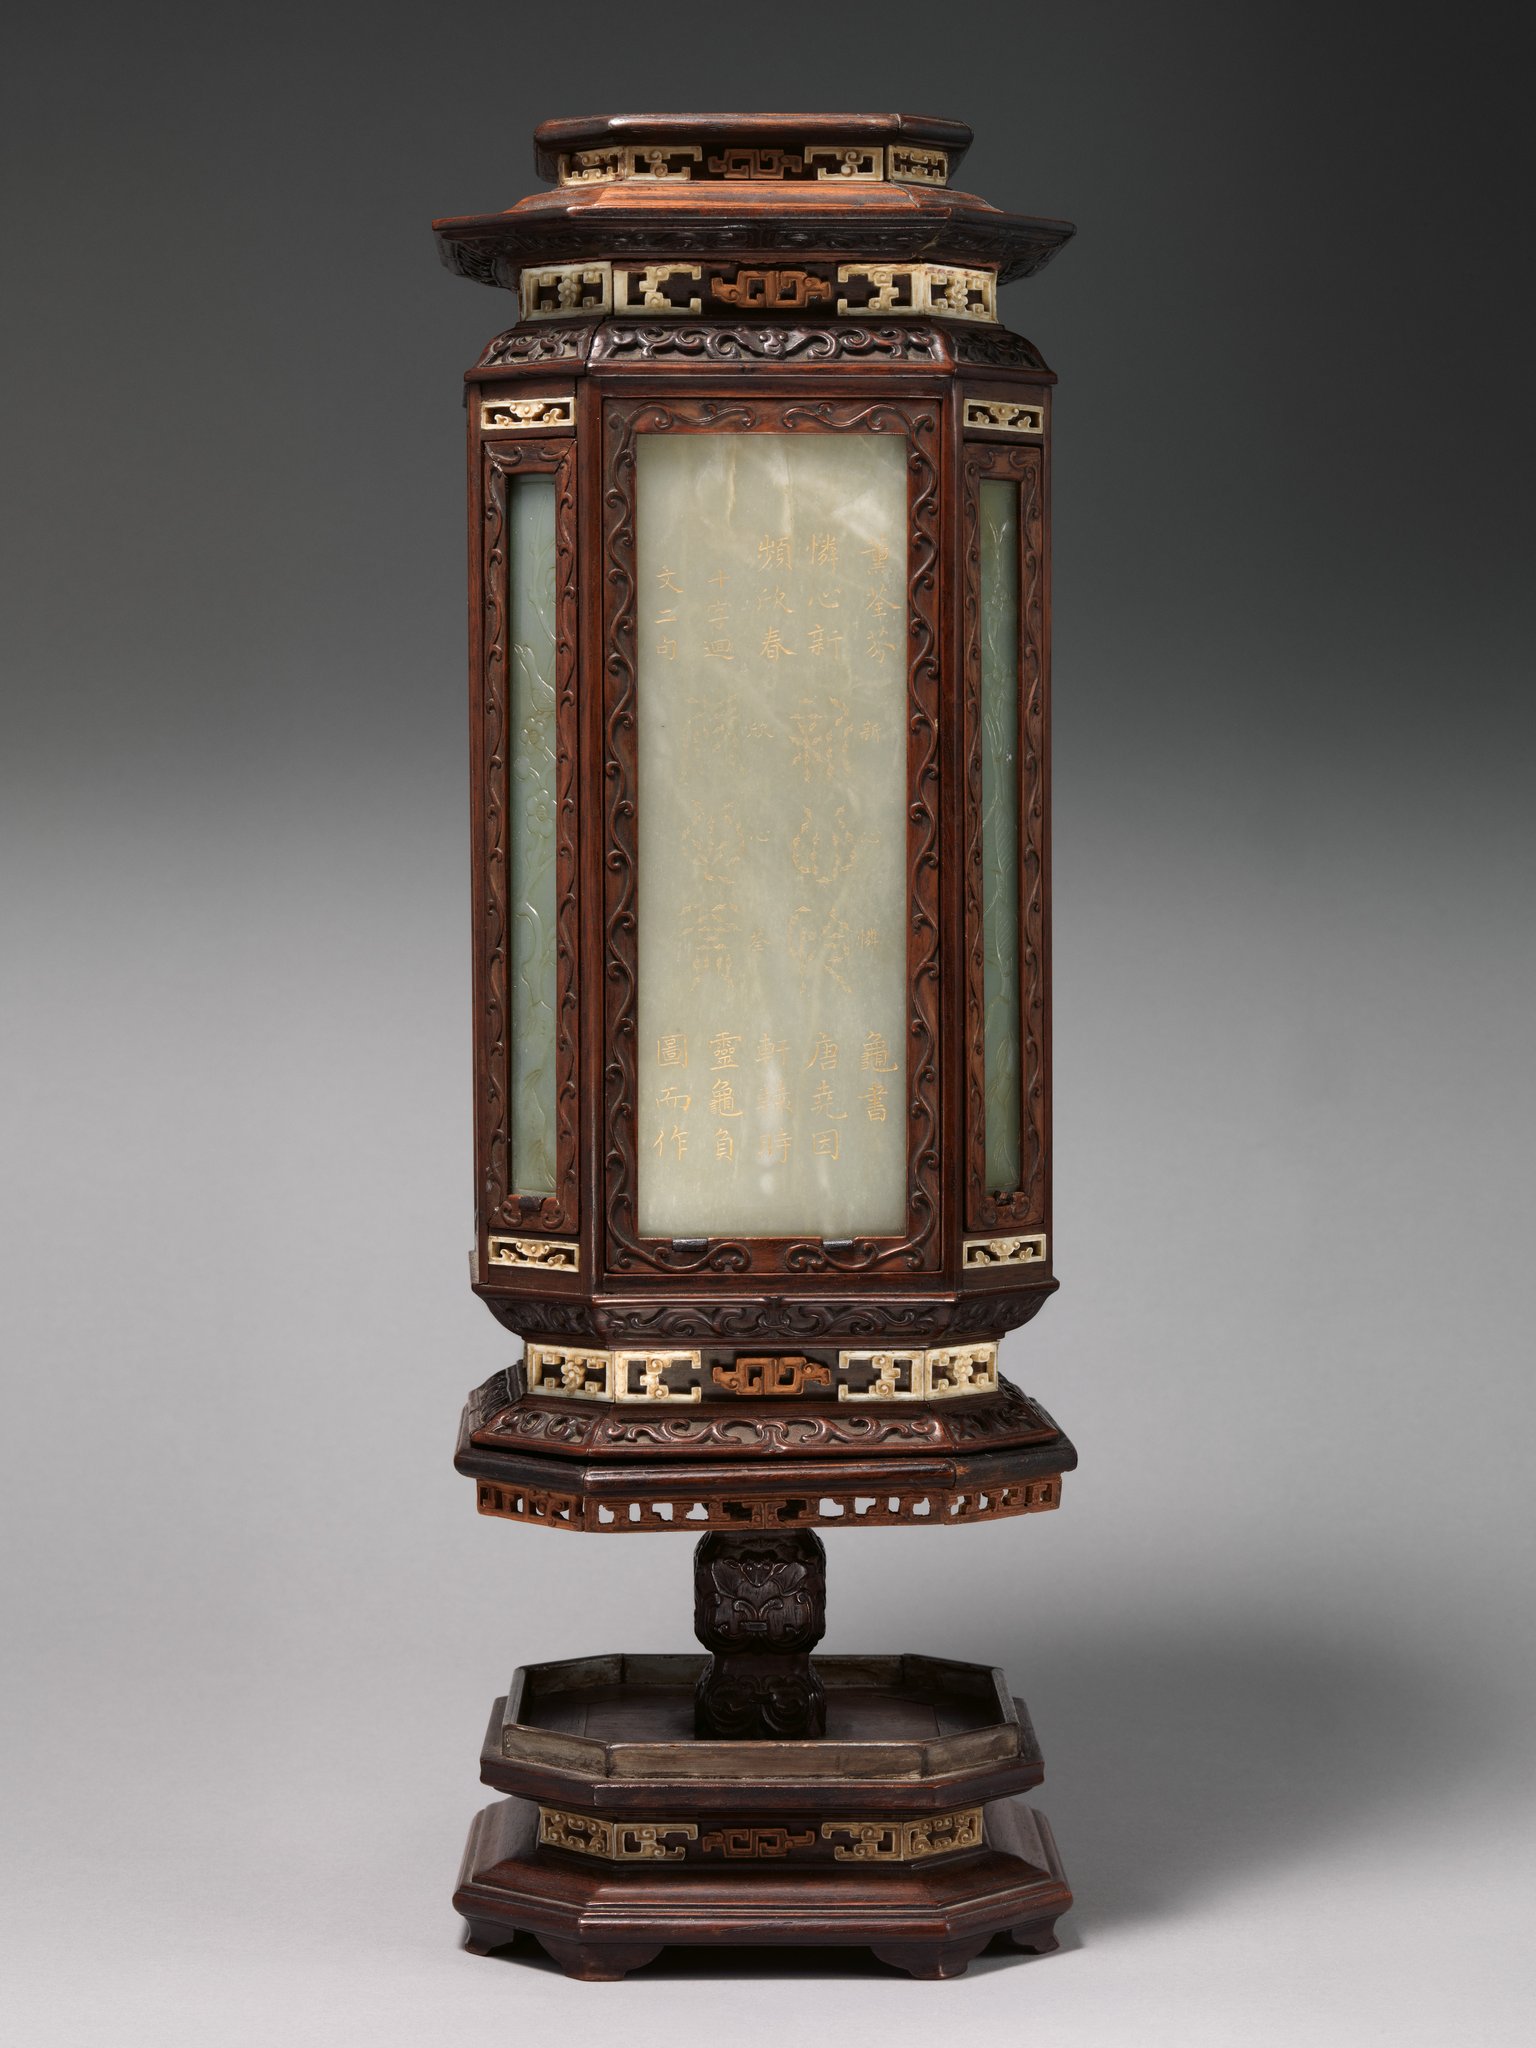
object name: one of a pair of lamp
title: One of a pair of lamps with archaic-style calligraphy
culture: chinese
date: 1751-1800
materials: ivory, jade, wood